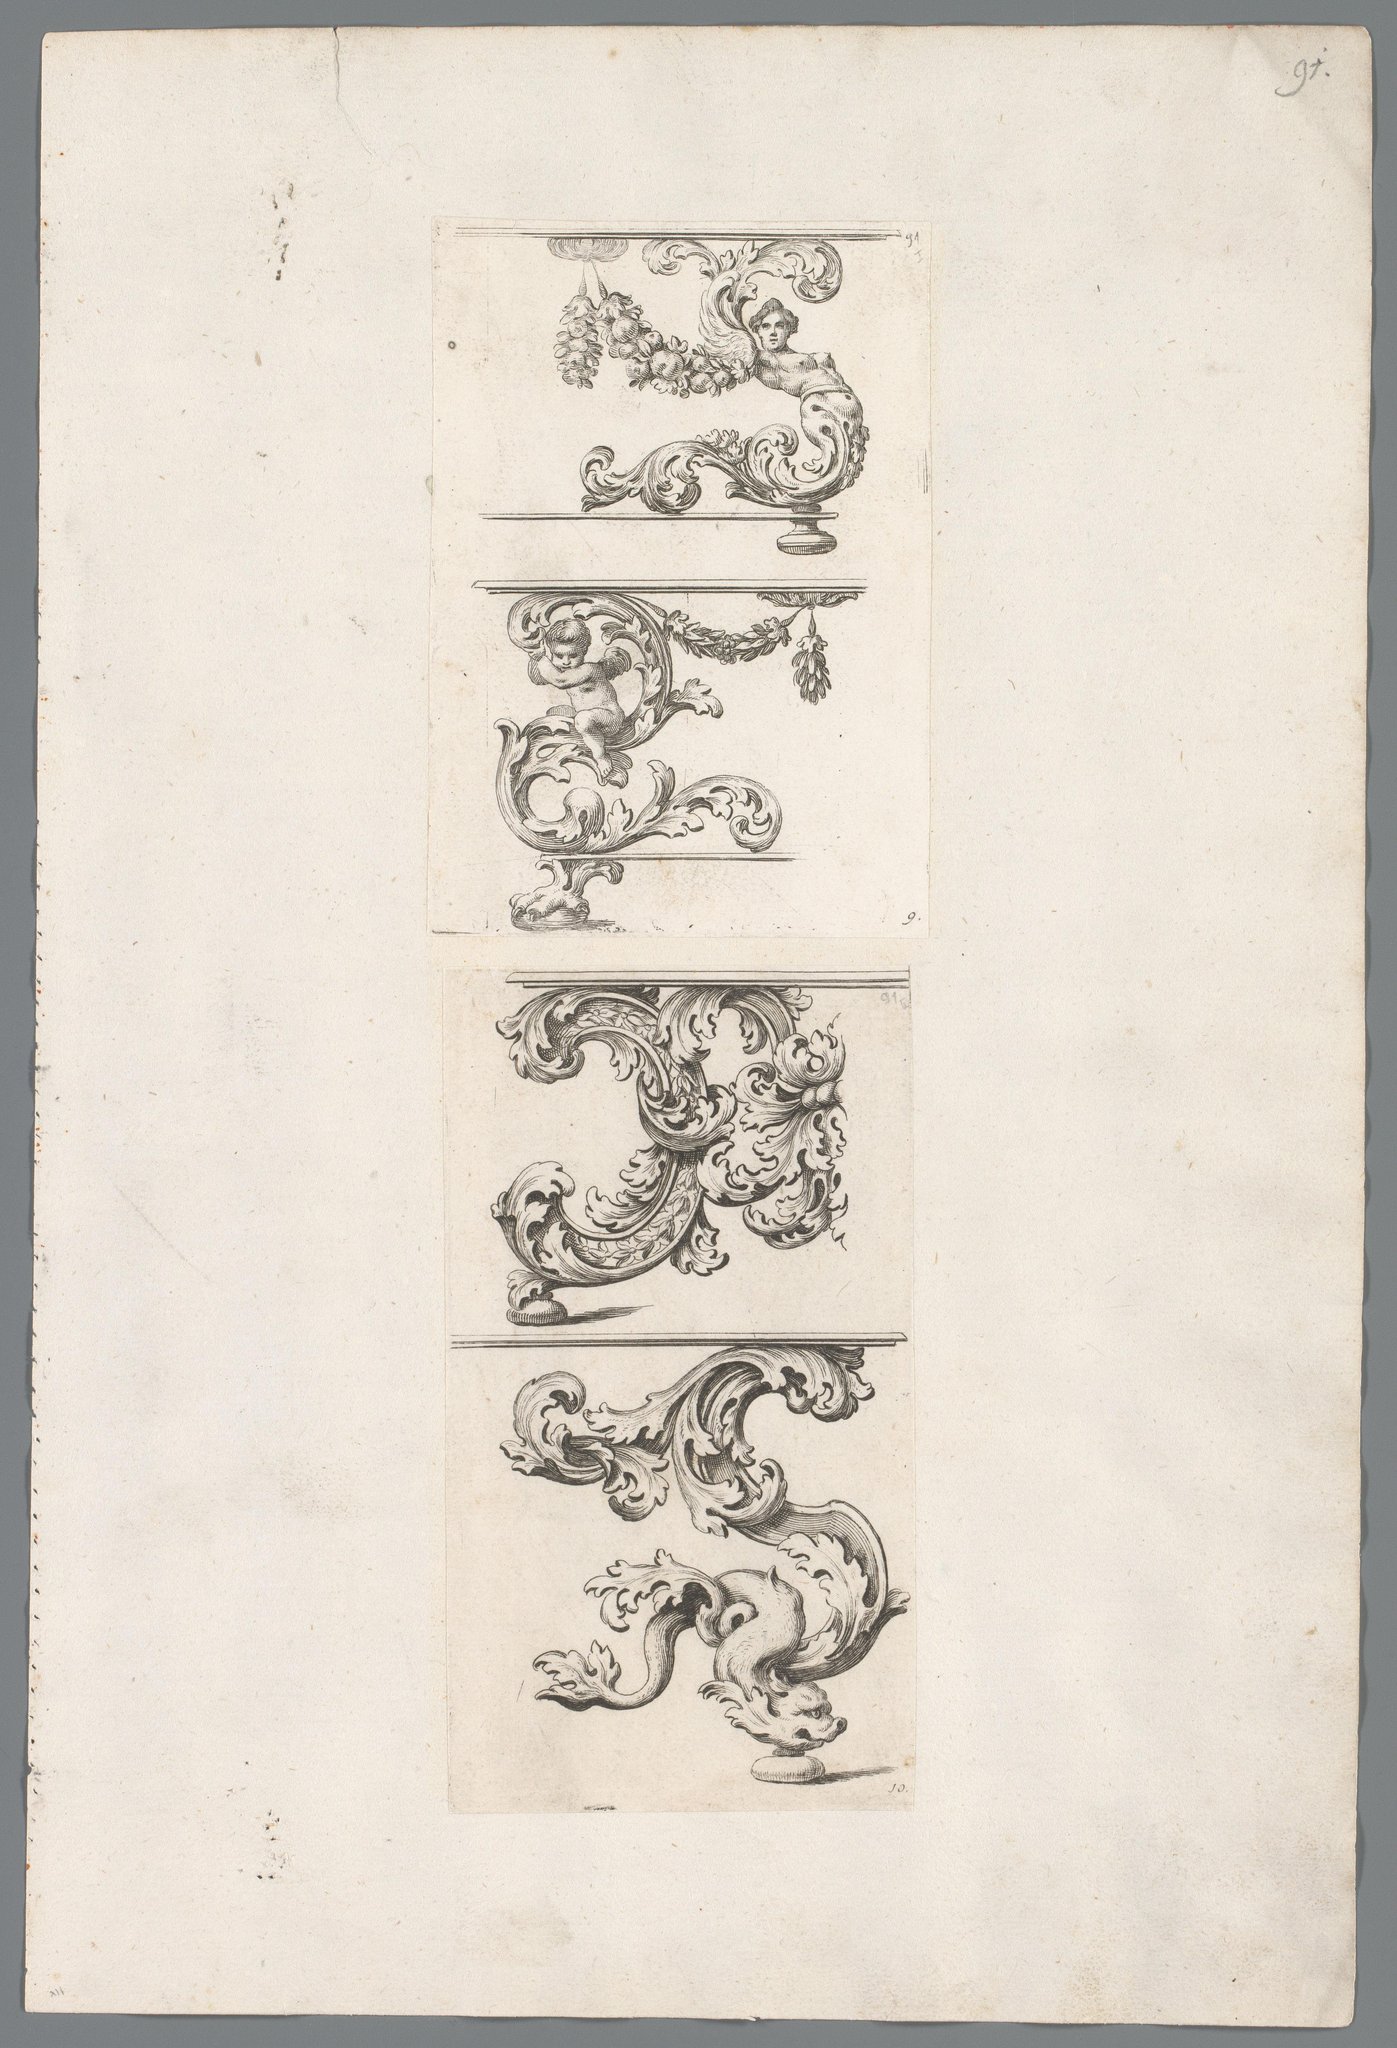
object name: ornament print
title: Romeins gebladerte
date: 1679-1700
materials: paper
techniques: etching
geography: augsburg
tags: acanthus ~ ornament, woman (showing herself) undressed, quasi-nude, ornament ~ festoon, garland, cupids: 'amores', 'amoretti', 'putti'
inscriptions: collector's mark: Lugt 2760, collector's mark: Lugt 2228